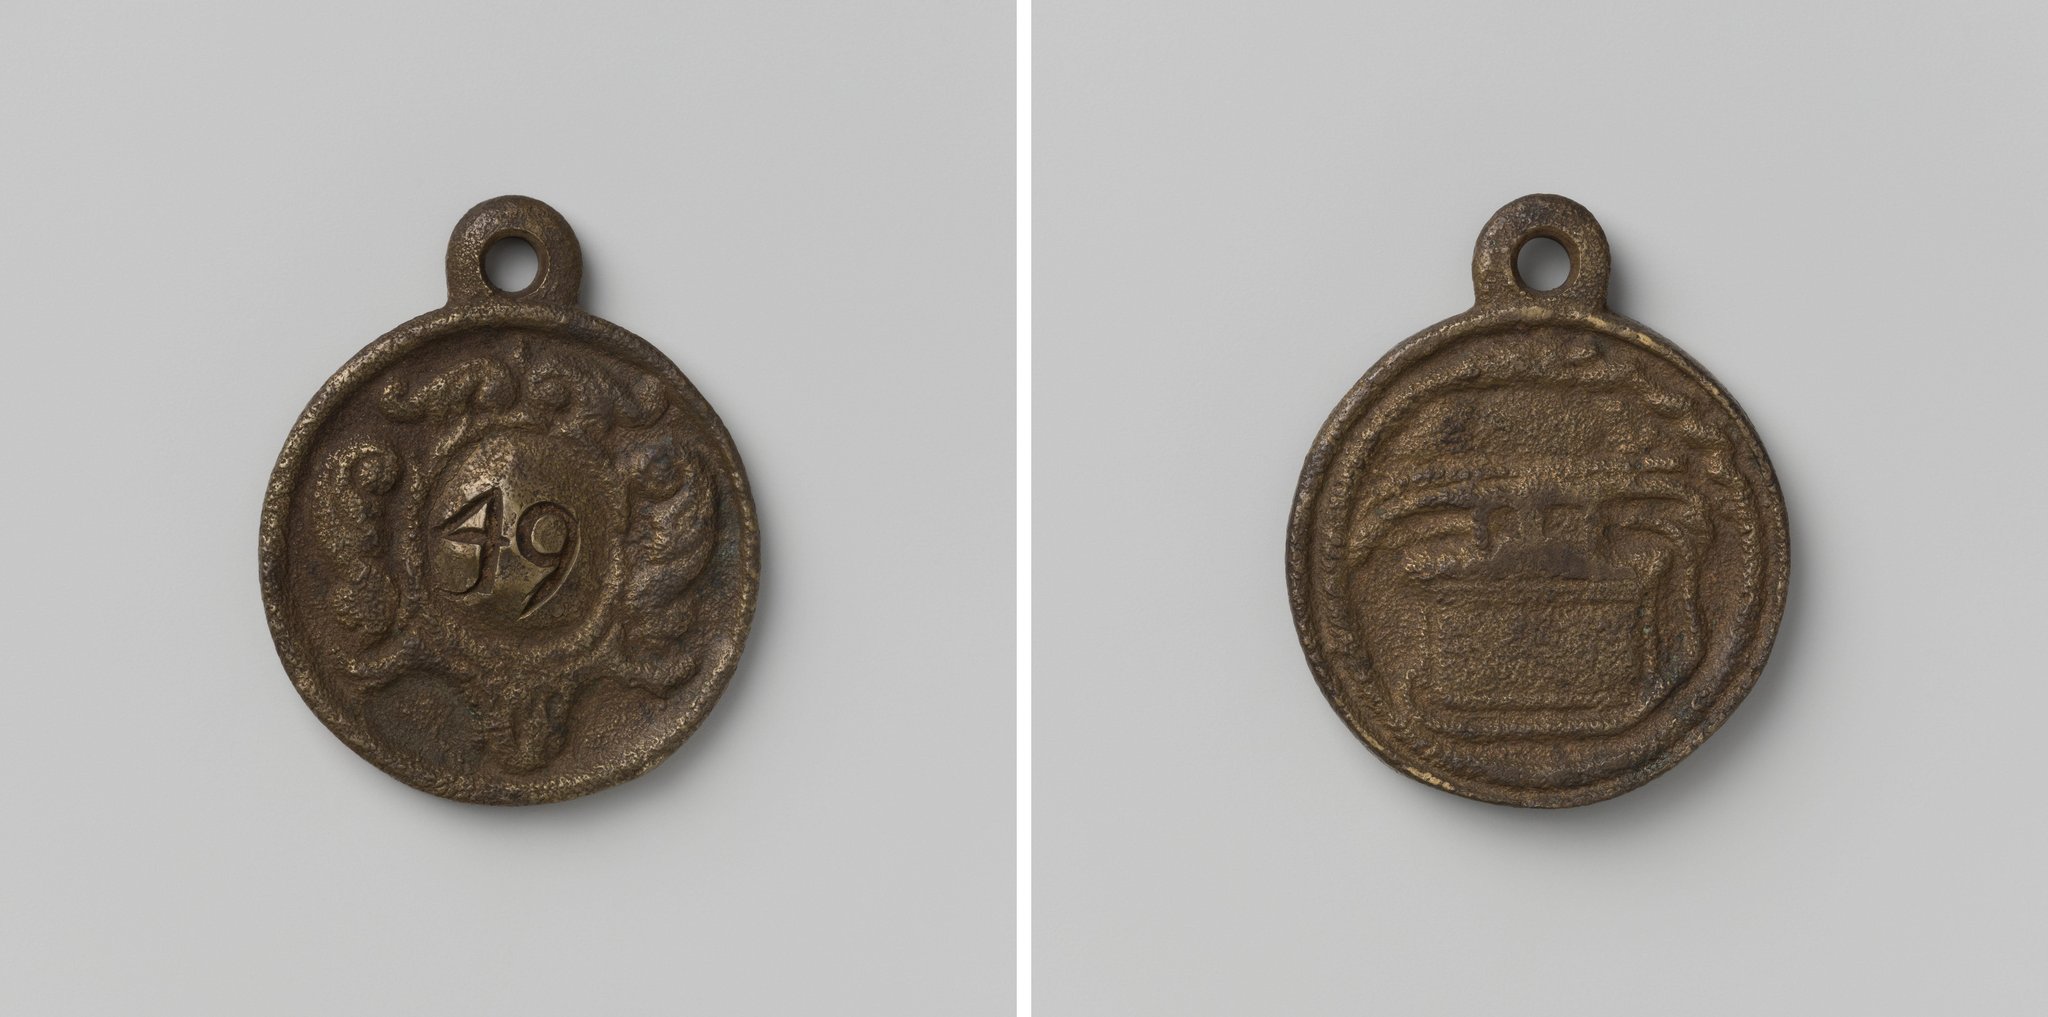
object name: fire engine medal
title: Onbekende plaats, brandspuitpenning met no. 49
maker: Anonymous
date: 1680-1800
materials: brass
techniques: casting, engraving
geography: netherlands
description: Messing penning aan draagoog. Voorzijde: cijfer 49 in cartouche. Keerzijde: brandspuit binnen slangerond